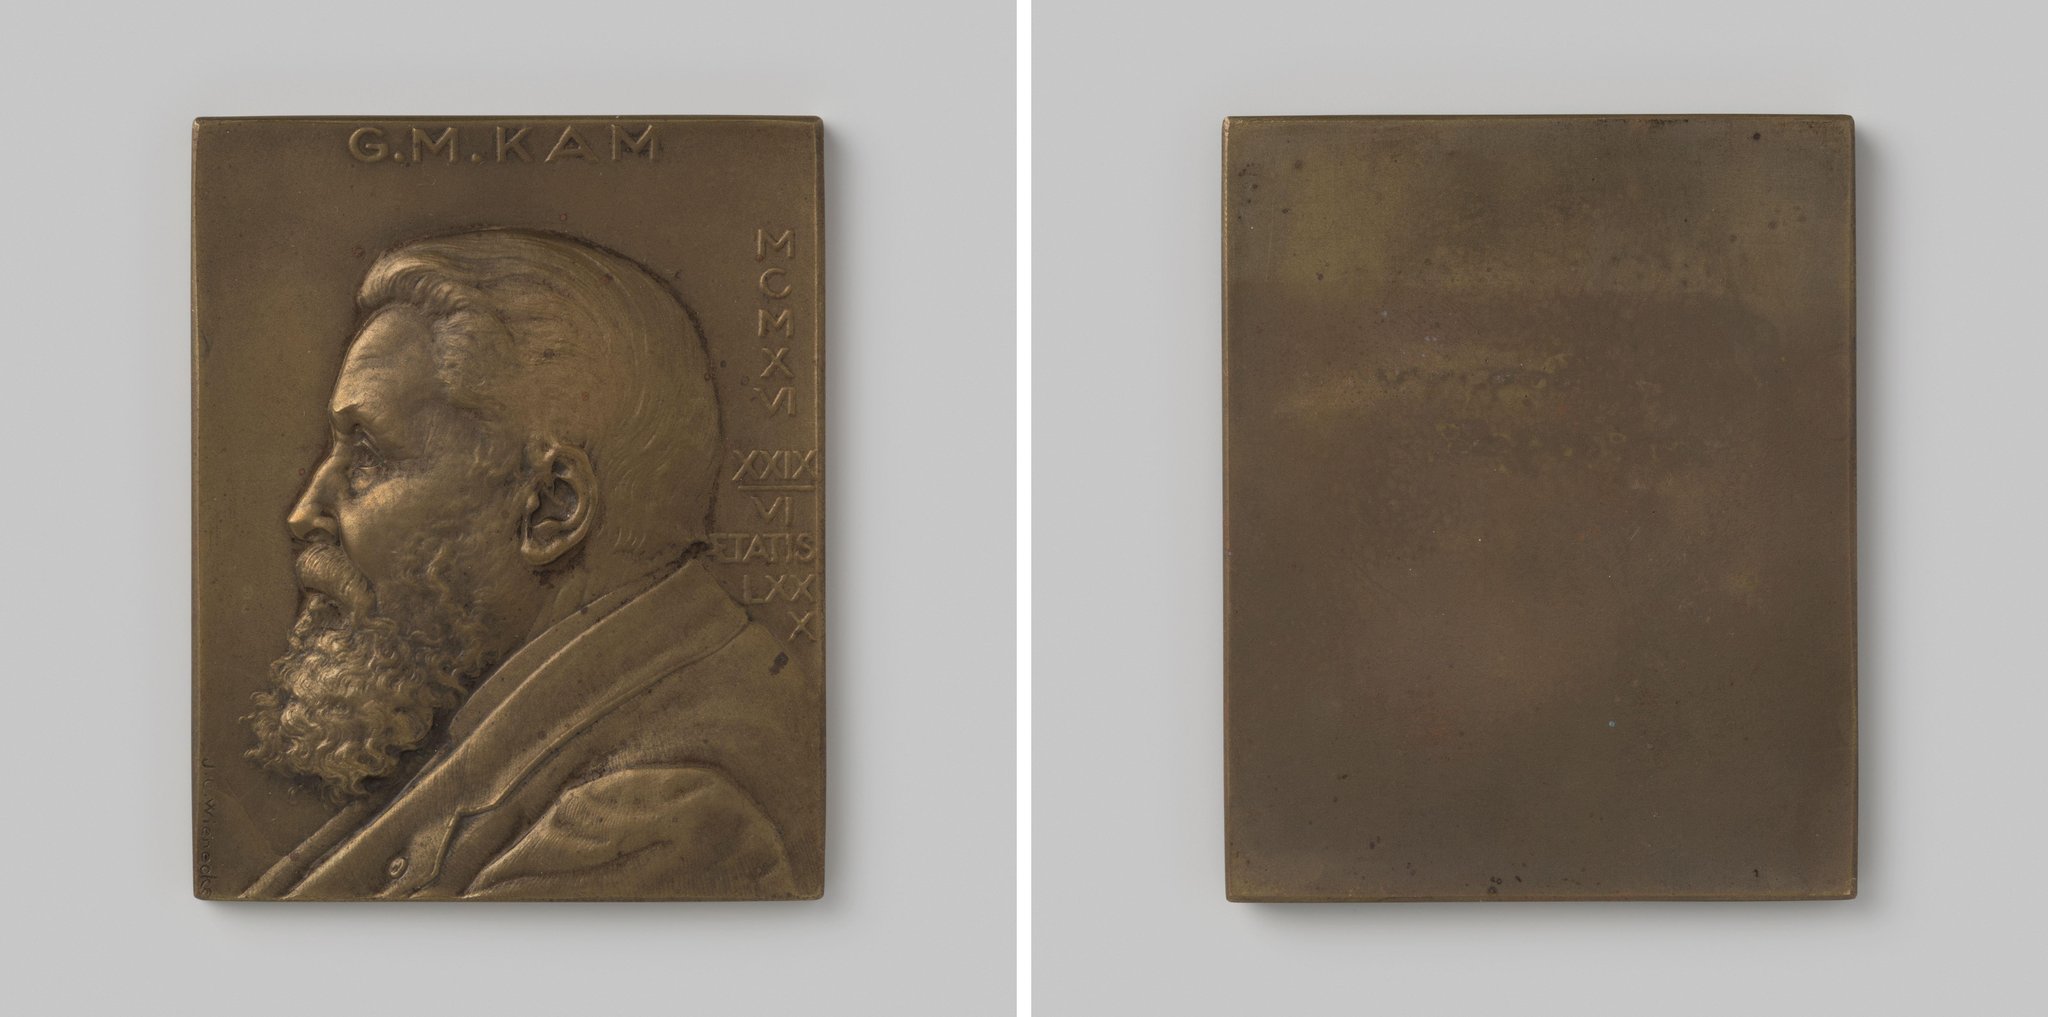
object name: history medal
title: Tachtigste verjaardag van G.M. Kam te Nijmegen 1916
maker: johannes cornelis wienecke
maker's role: medailleur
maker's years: 1872-1945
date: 1914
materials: bronze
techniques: striking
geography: utrecht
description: Eenzijdige rechthoekige bronzen plaquette met het borstbeeld van Kam naar links met tekst bovenaan en rechts.